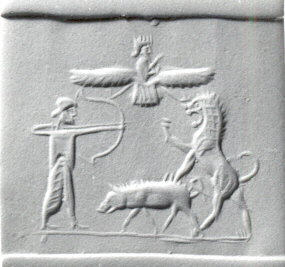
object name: cylinder seal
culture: achaemenid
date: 600-301 BCE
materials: stone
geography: iran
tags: men,hunting,lions,pigs